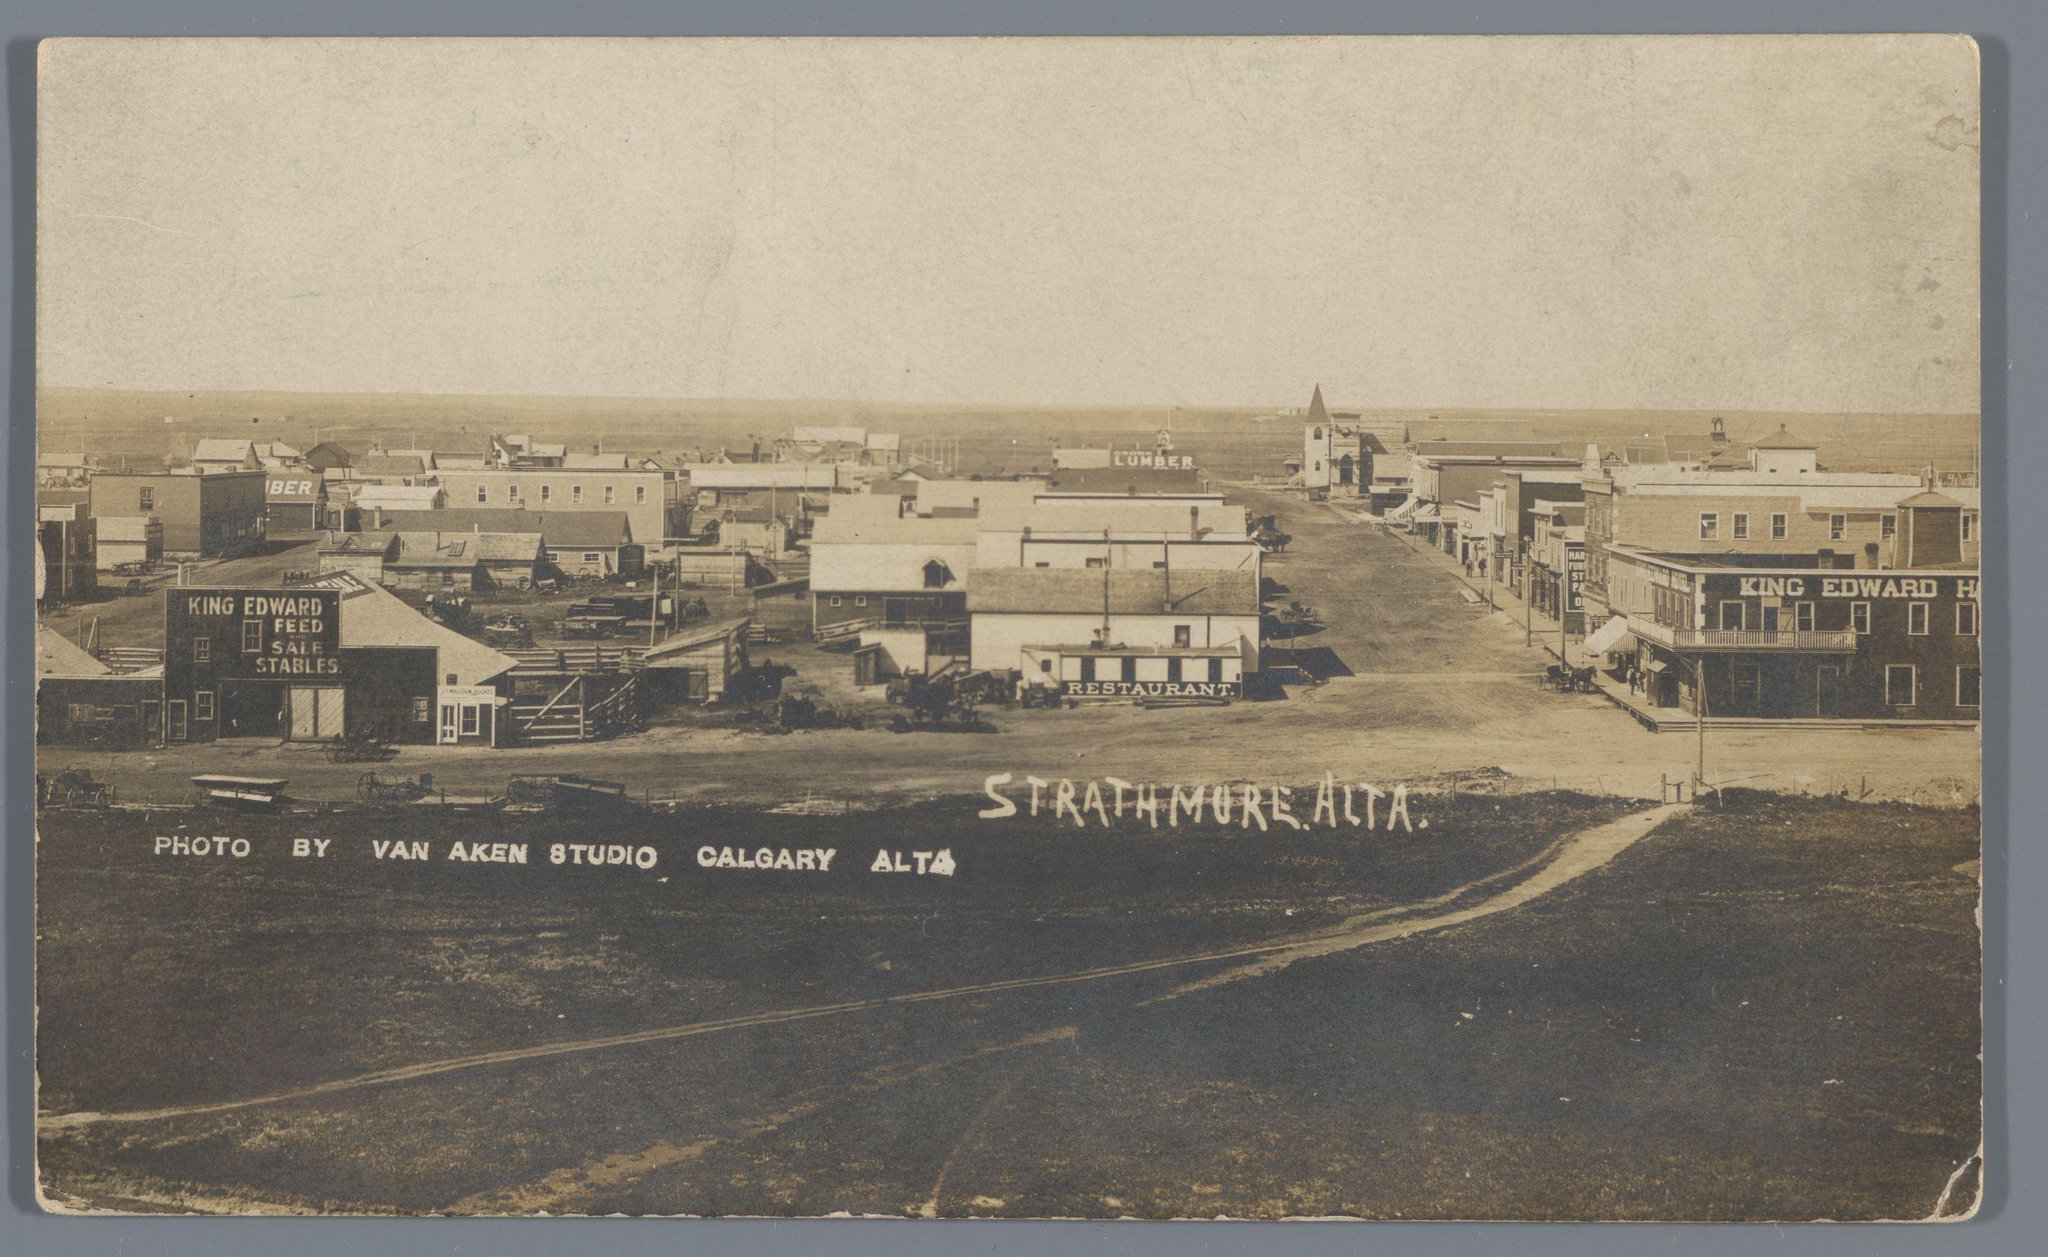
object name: ansichtkaart, prentbriefkaart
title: Gezicht op Strathmore, Altona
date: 1900-1920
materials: photographic support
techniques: gelatin silver print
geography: calgary